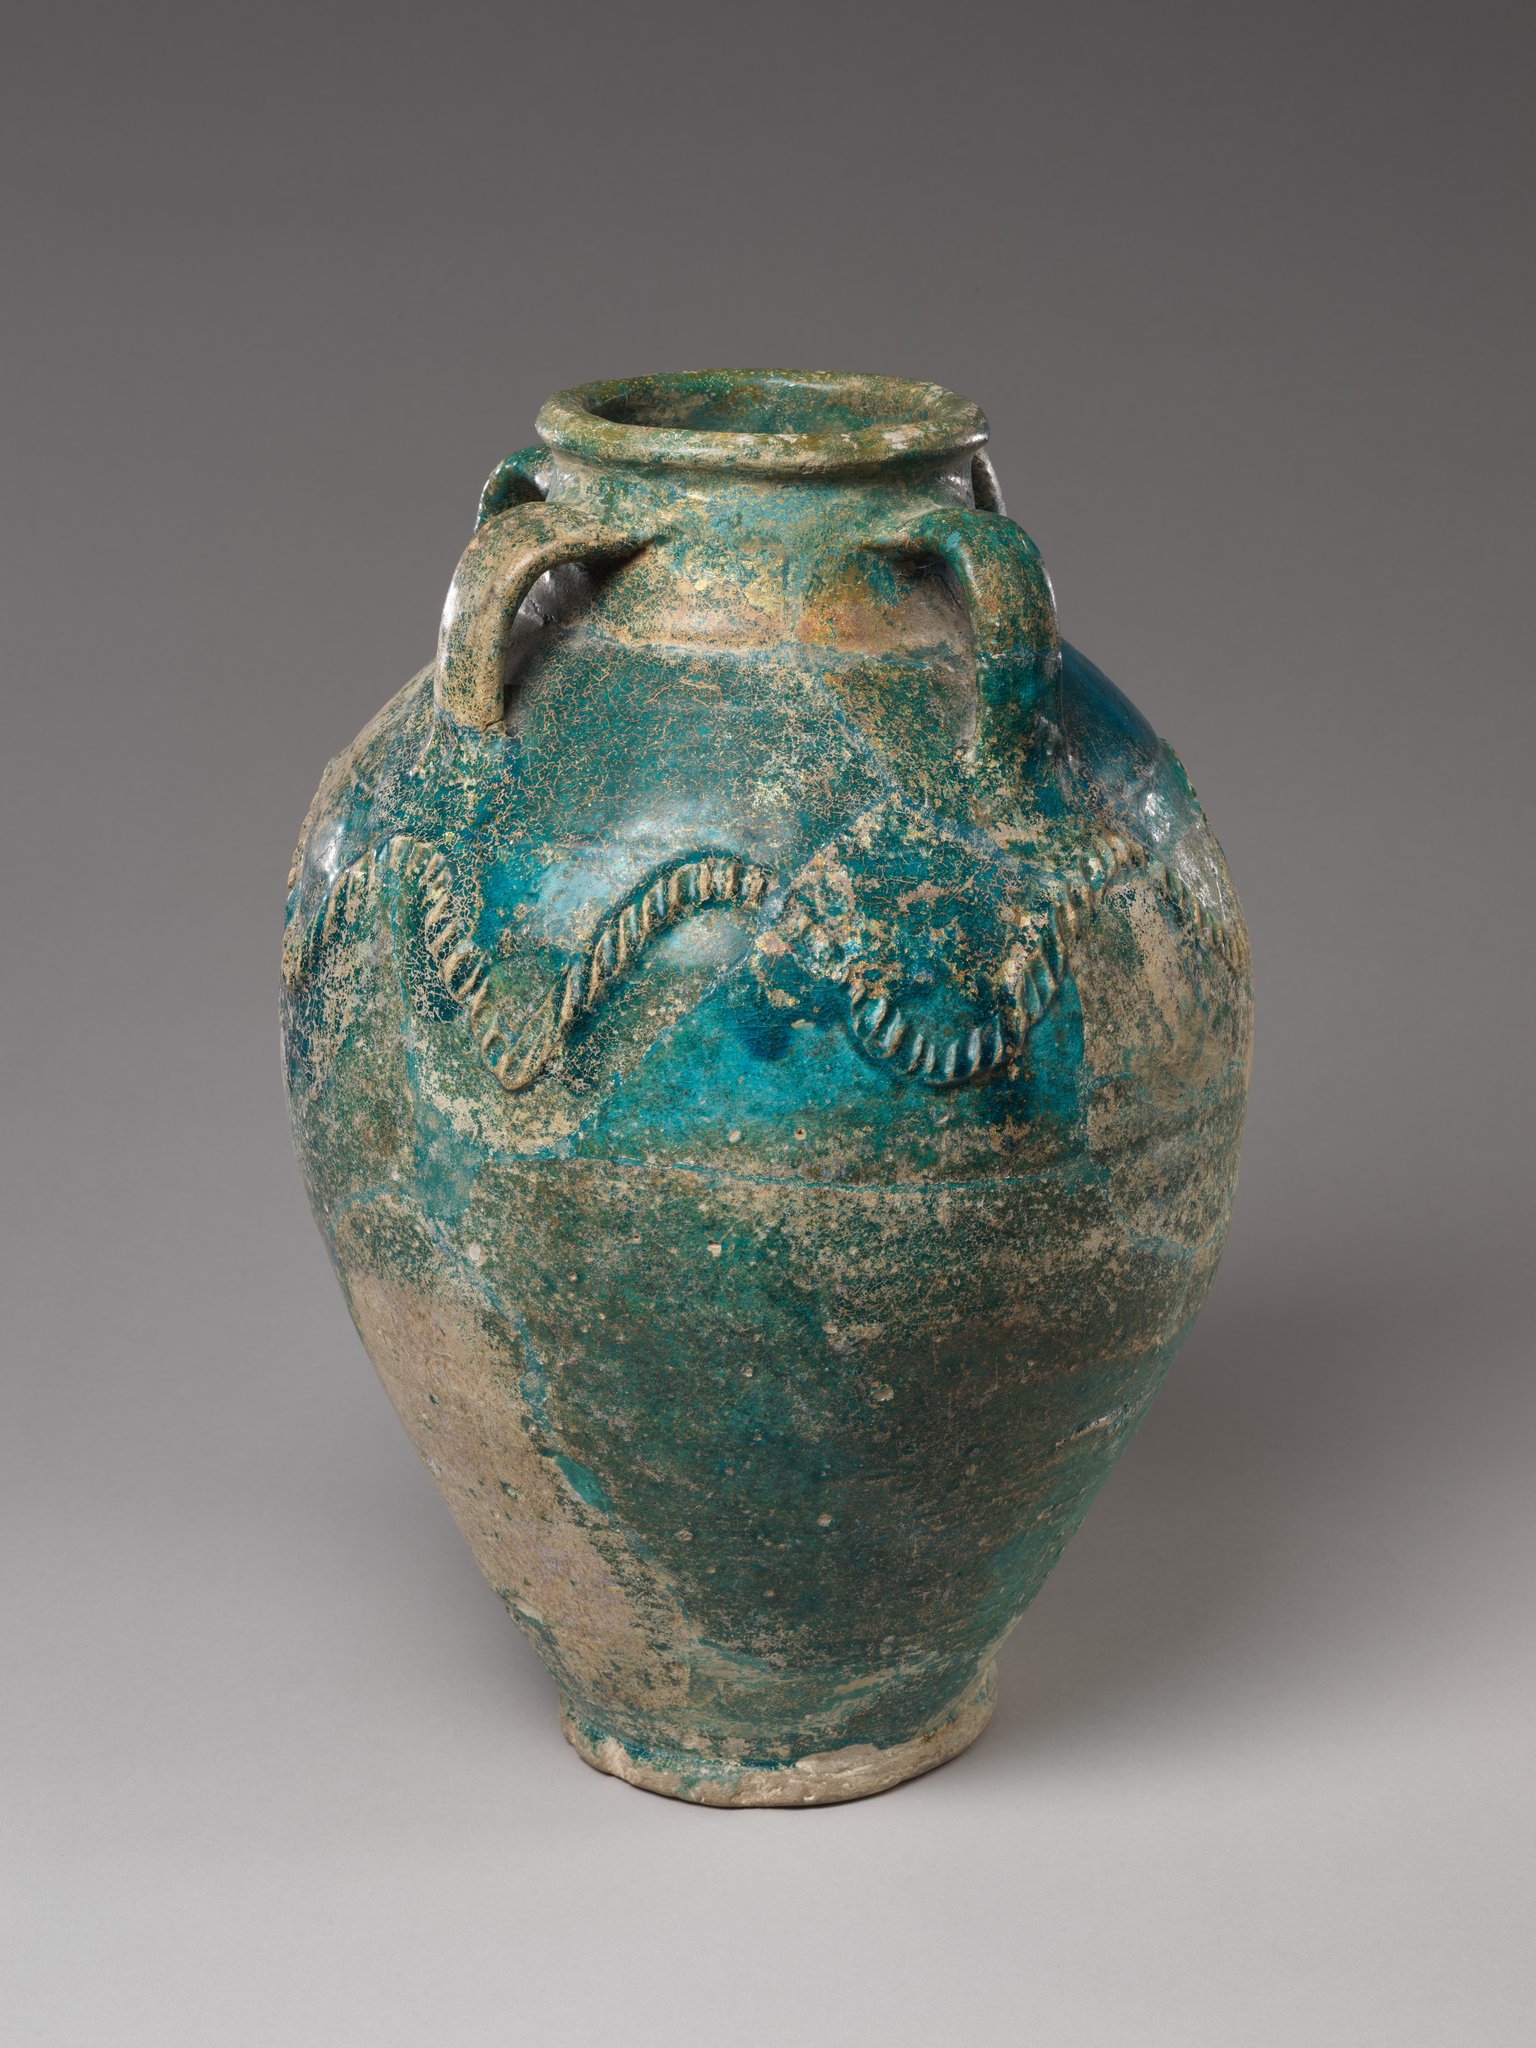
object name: jug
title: Four handled storage jar with rope-pattern design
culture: iranian or iraqi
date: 901-1200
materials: earthenware, glaze